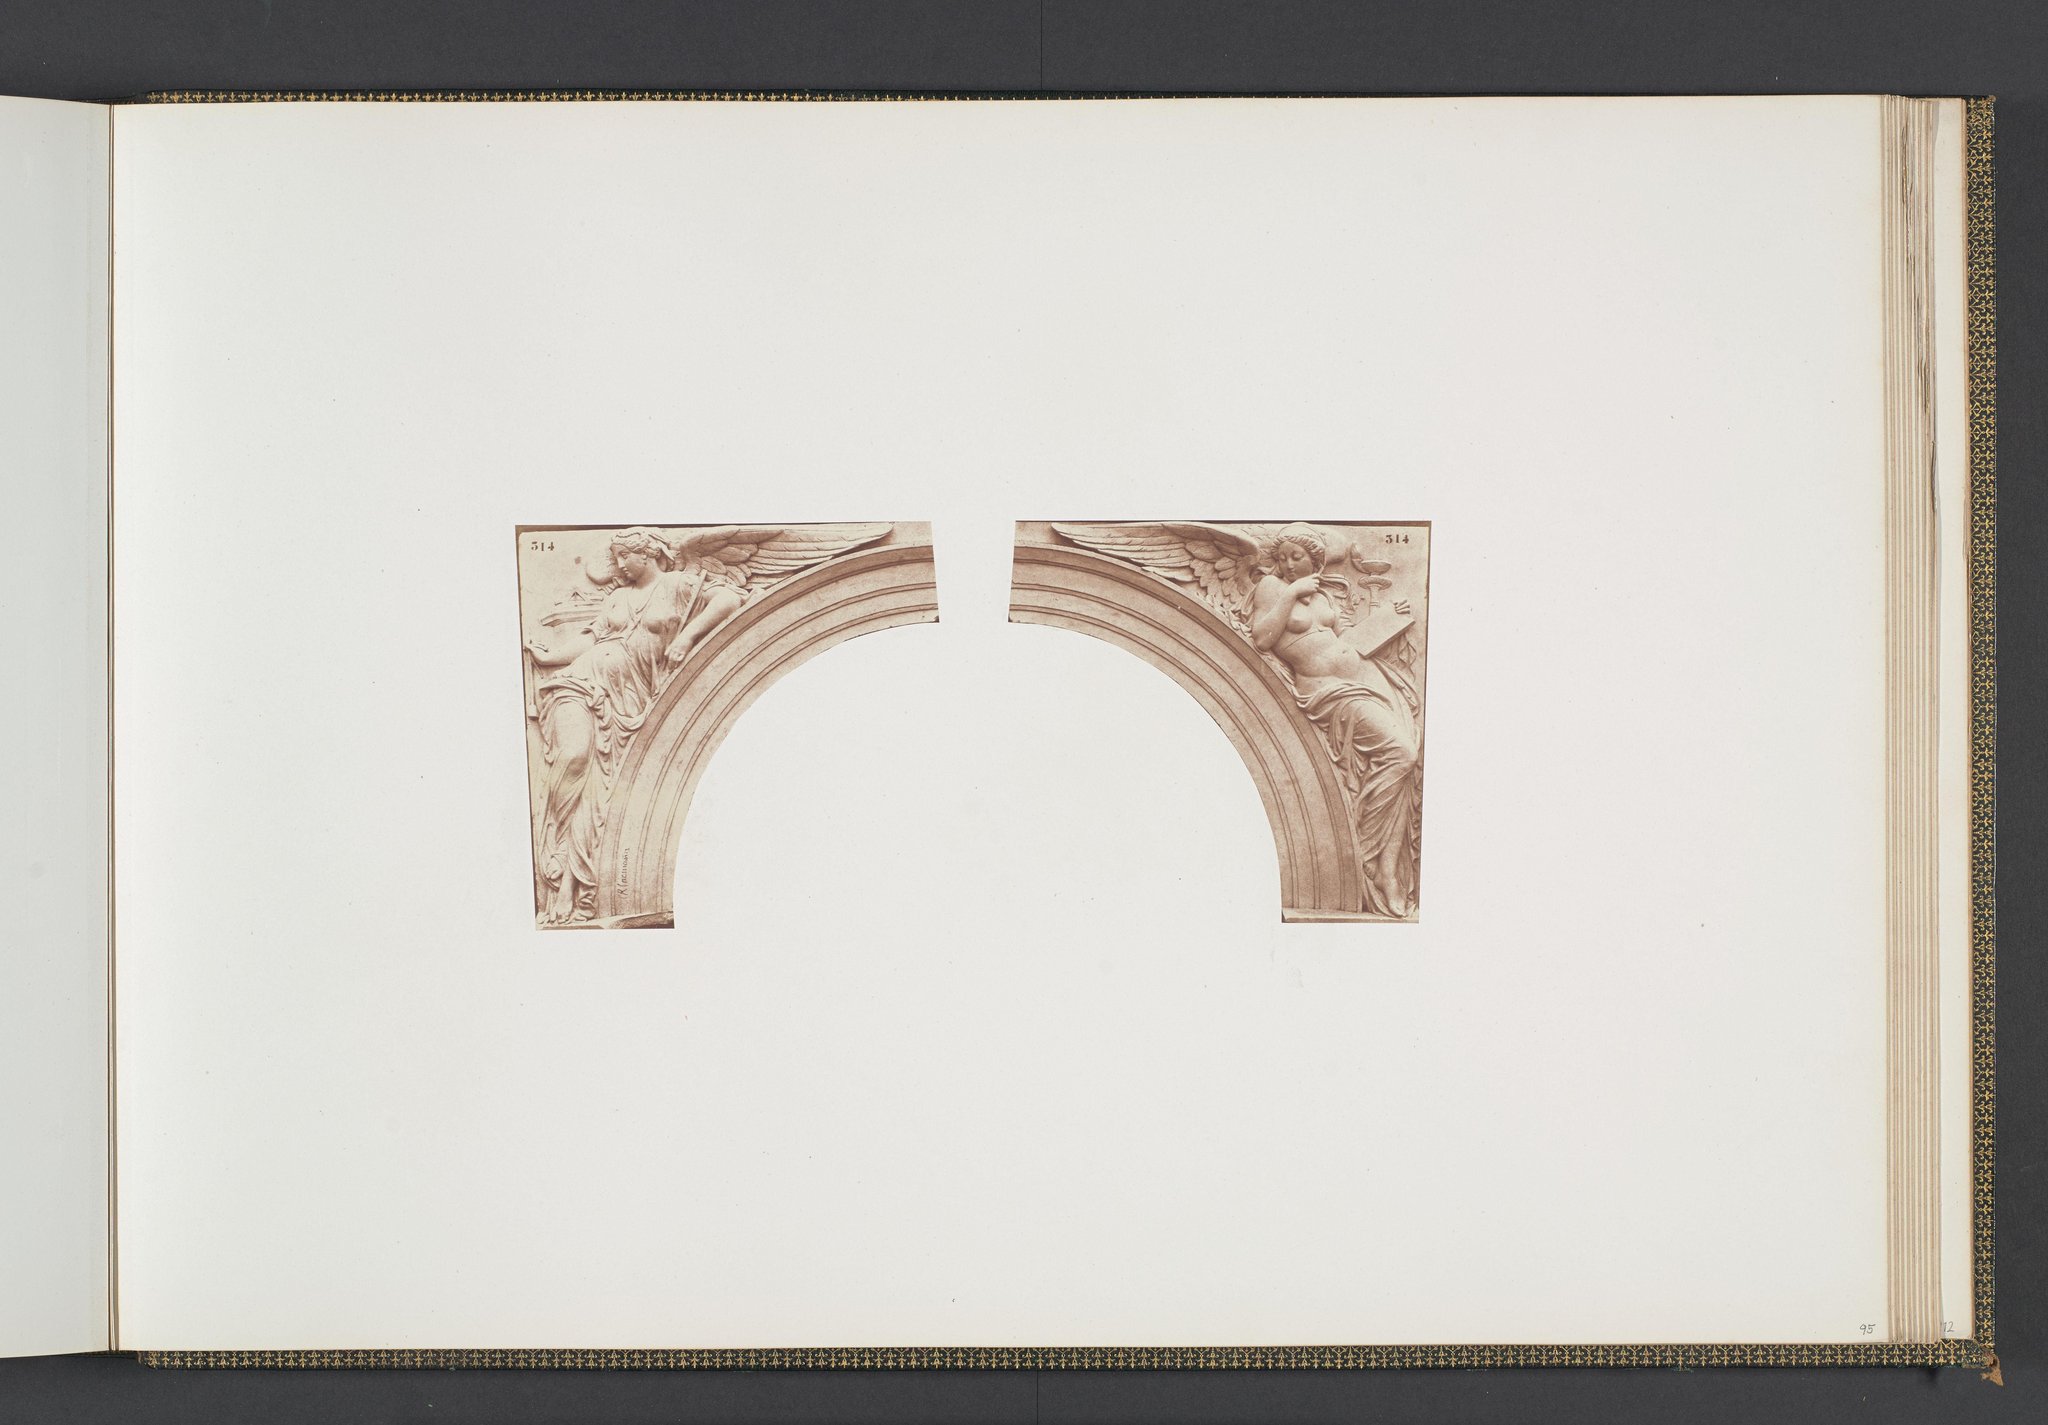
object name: photograph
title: Gipsmodellen voor beeldhouwwerken op het Palais du Louvre: links "La Science moderne" en rechts "L'Art" door Emile Seurre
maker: édouard denis baldus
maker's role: fotograaf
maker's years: 1813-1889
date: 1855-1857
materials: paper, photographic support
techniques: salted paper print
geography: paris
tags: piece of sculpture, reproduction of a piece of sculpture, permanent exhibition, museum, paris, tuileries palace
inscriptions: number: ‘314 beide’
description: Onderdeel van Réunion des Tuileries au Louvre 1852-1857, album 2.